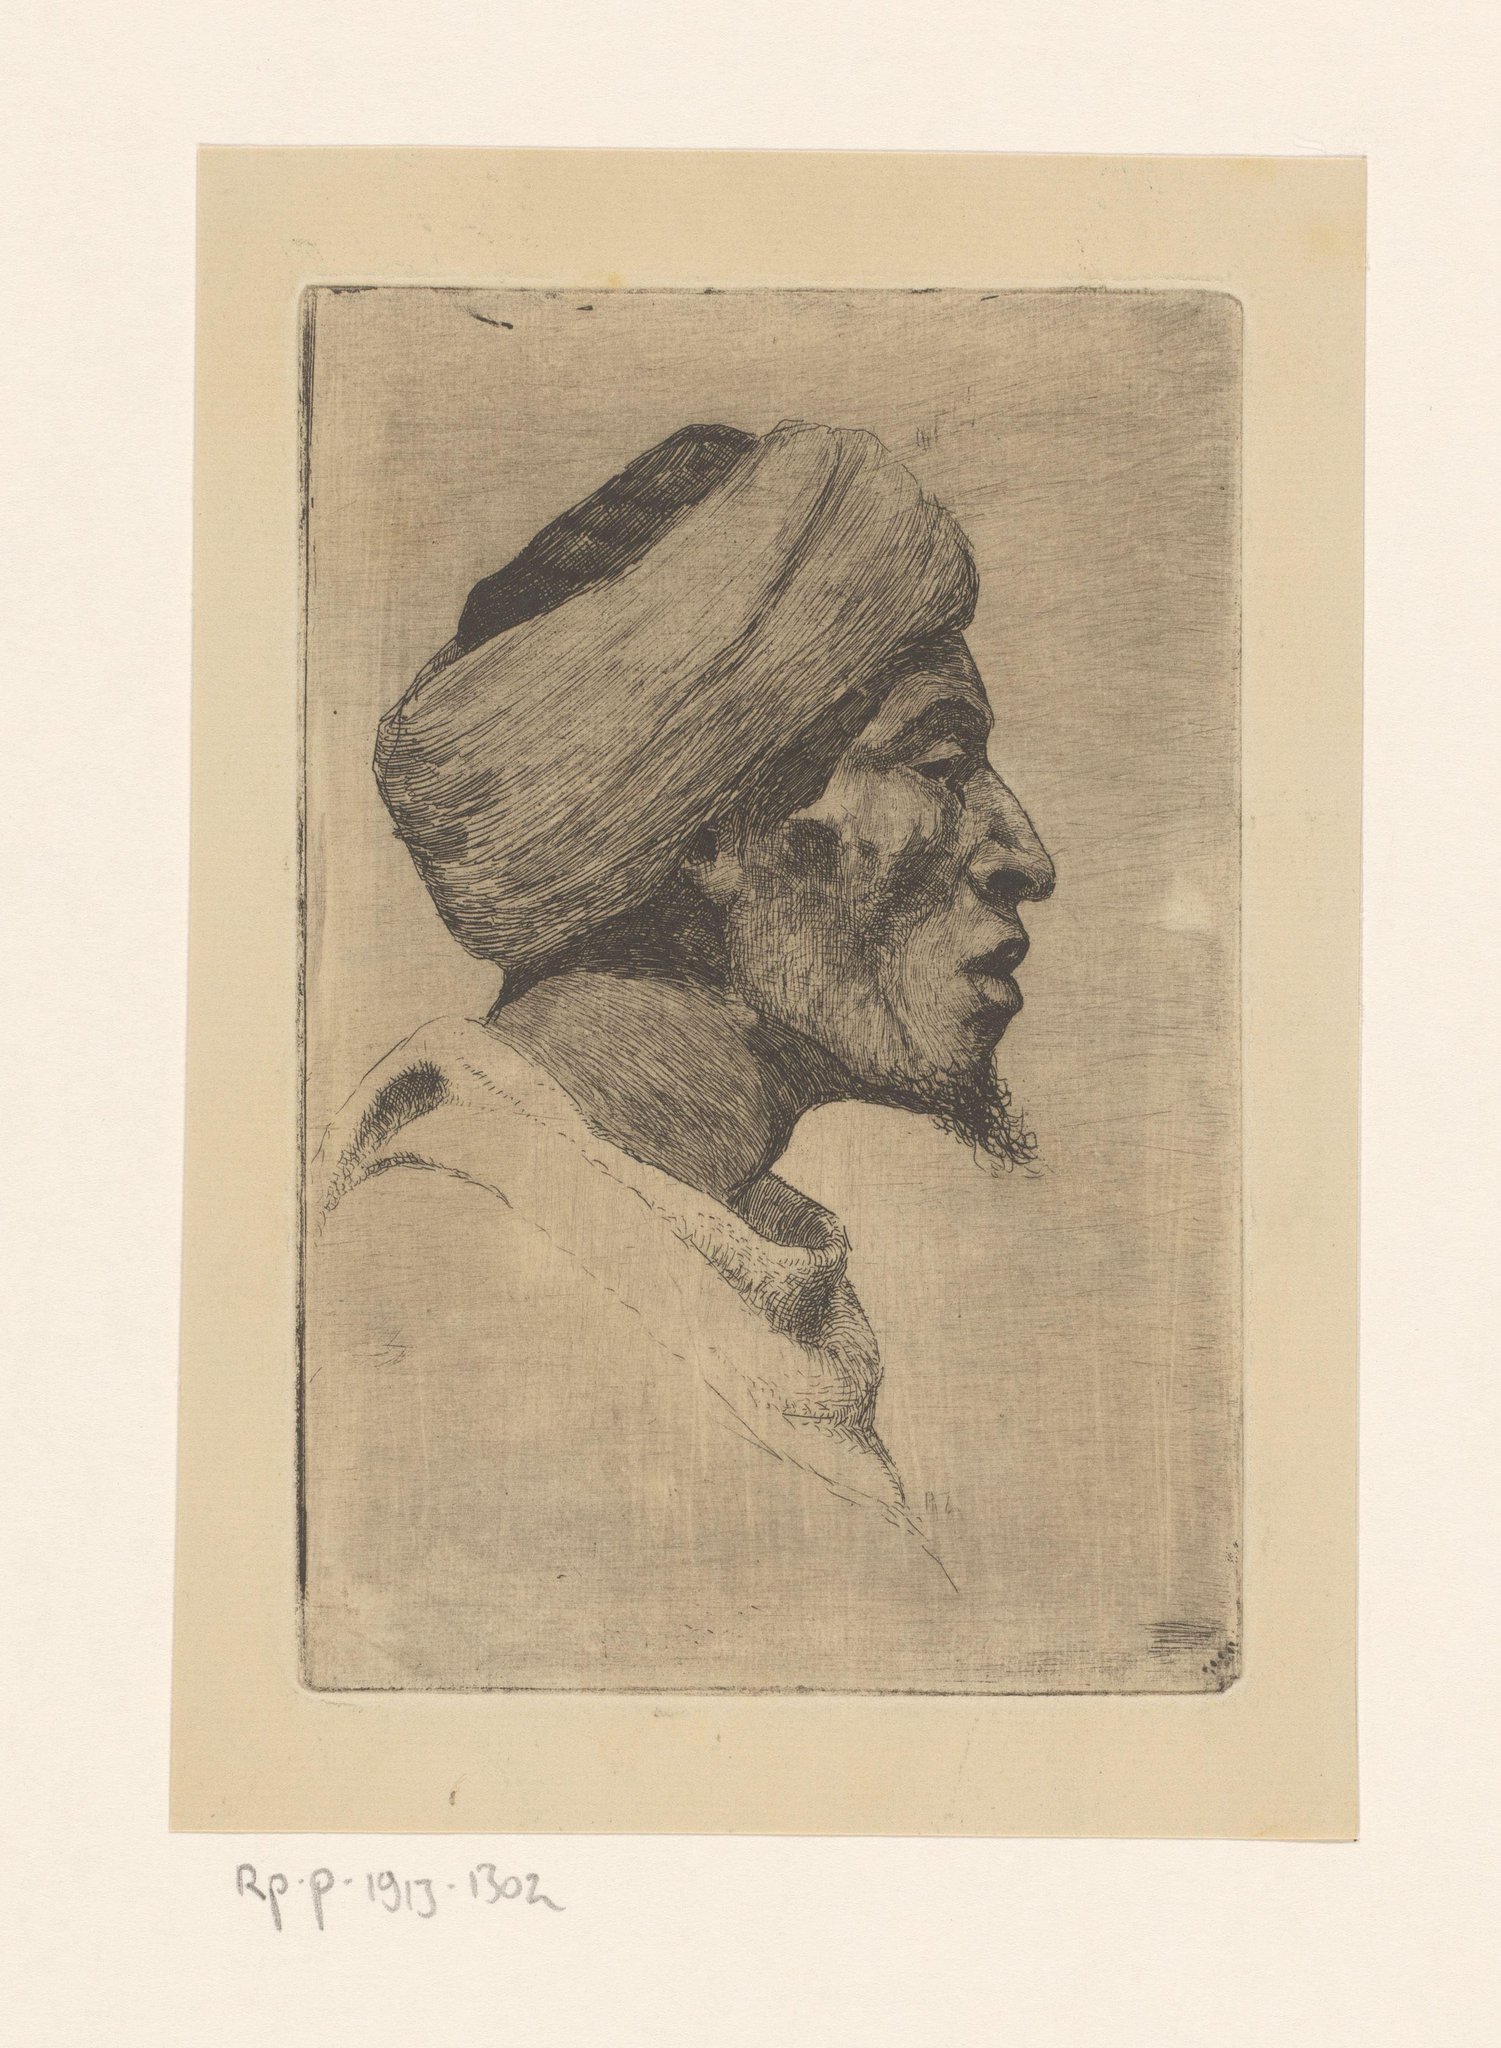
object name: print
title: Man met tulband en baard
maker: philip zilcken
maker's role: draughtsman, painter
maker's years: 1857-1930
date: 1867-1890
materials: paper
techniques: drypoint, etching, intaglio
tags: africans, head-gear: turban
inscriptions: collector's mark: Lugt 2233